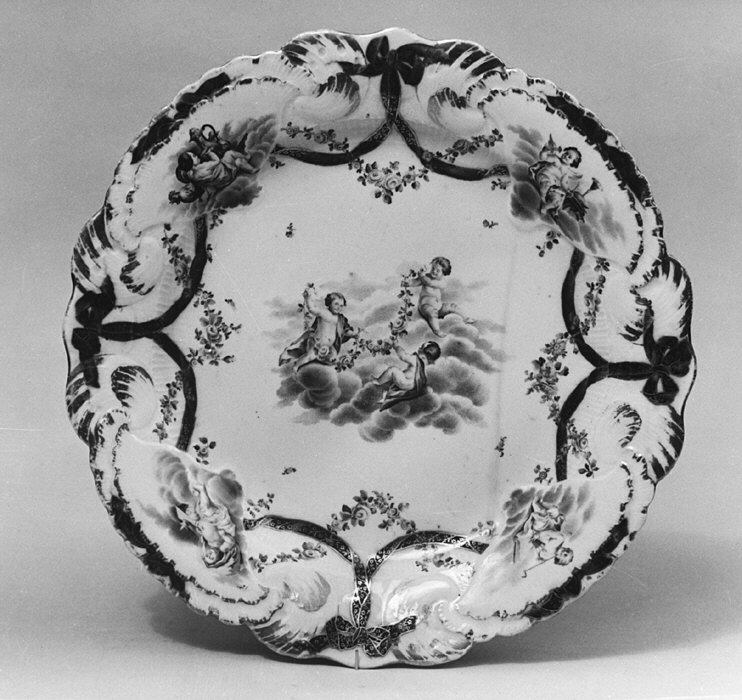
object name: plate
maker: imperial porcelain manufactory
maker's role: manufactory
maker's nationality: austrian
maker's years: 1744-1864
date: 1760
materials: hard paste porcelain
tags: garlands,putti